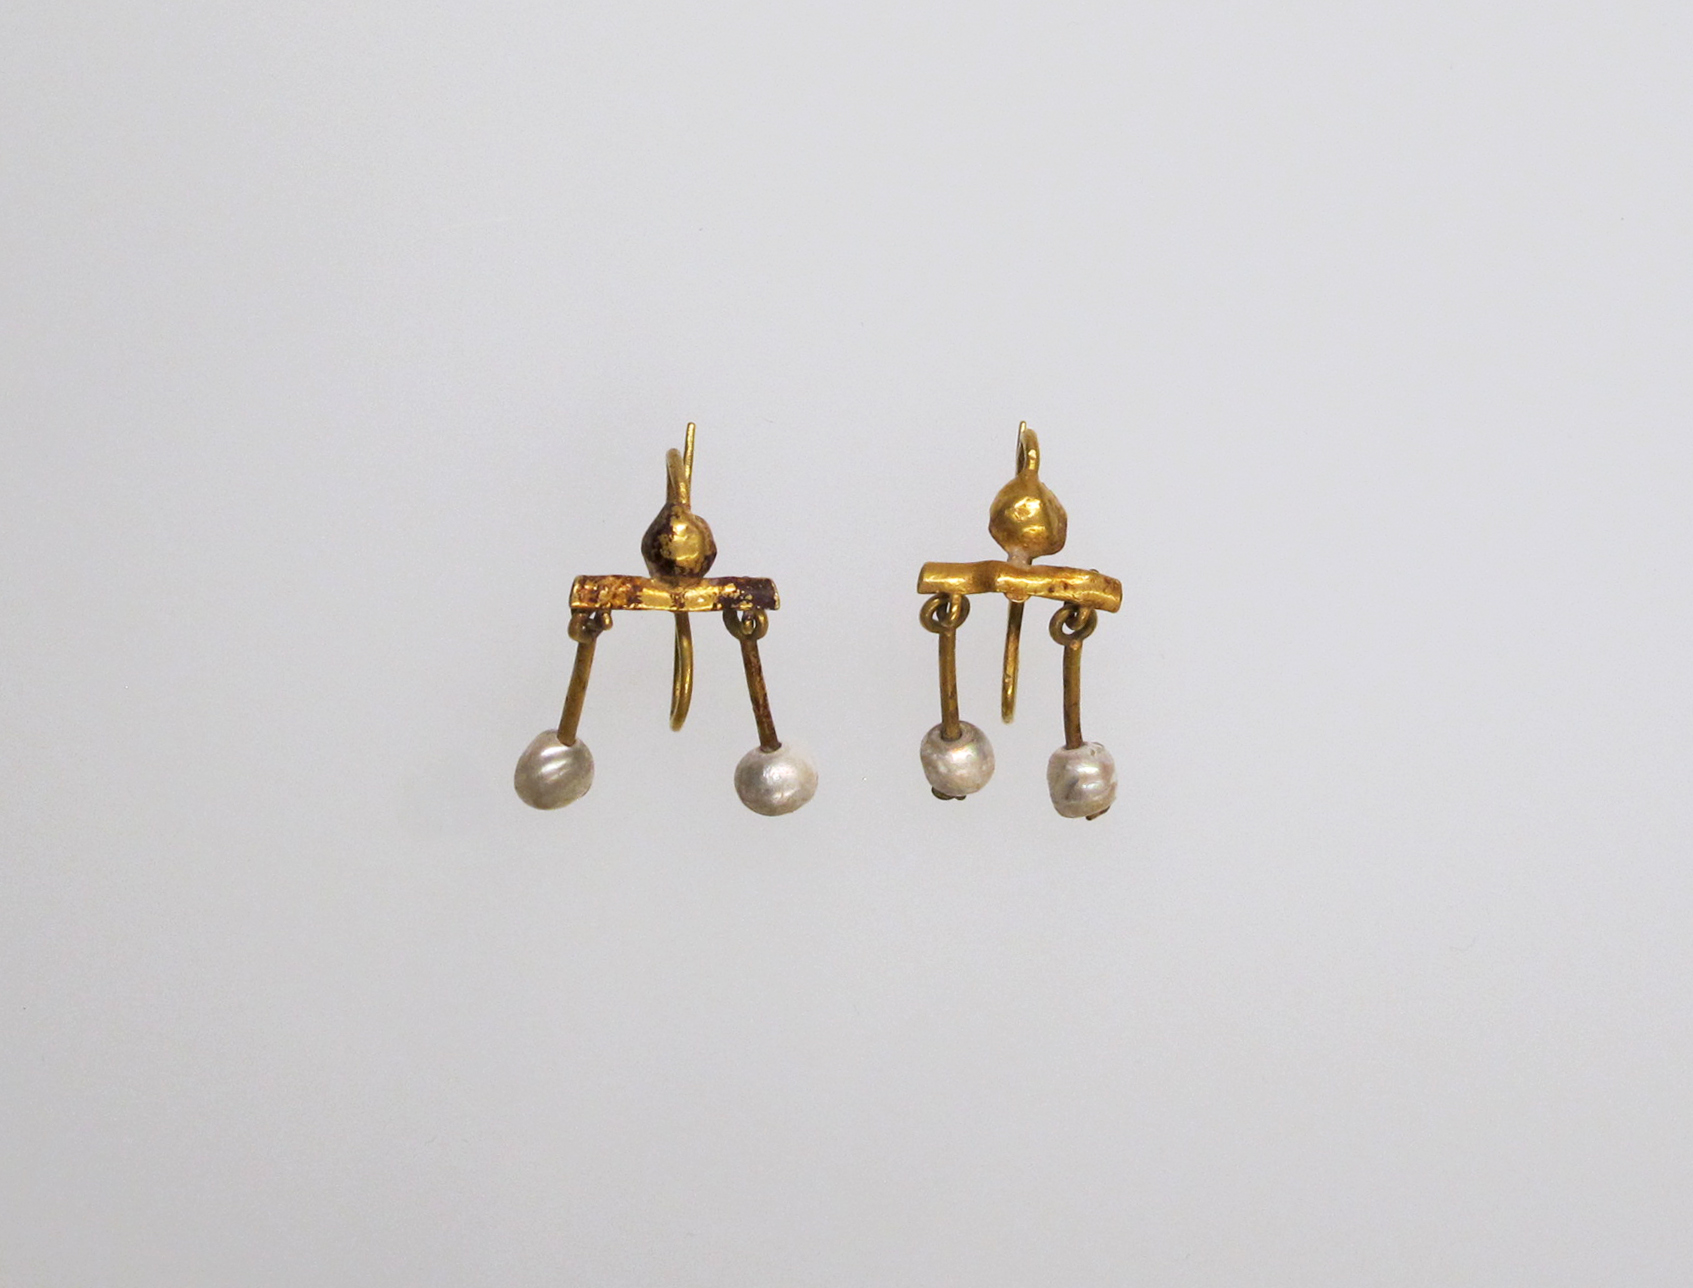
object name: earring with pendant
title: Gold and pearl earring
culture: roman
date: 1-100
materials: gold, pearl